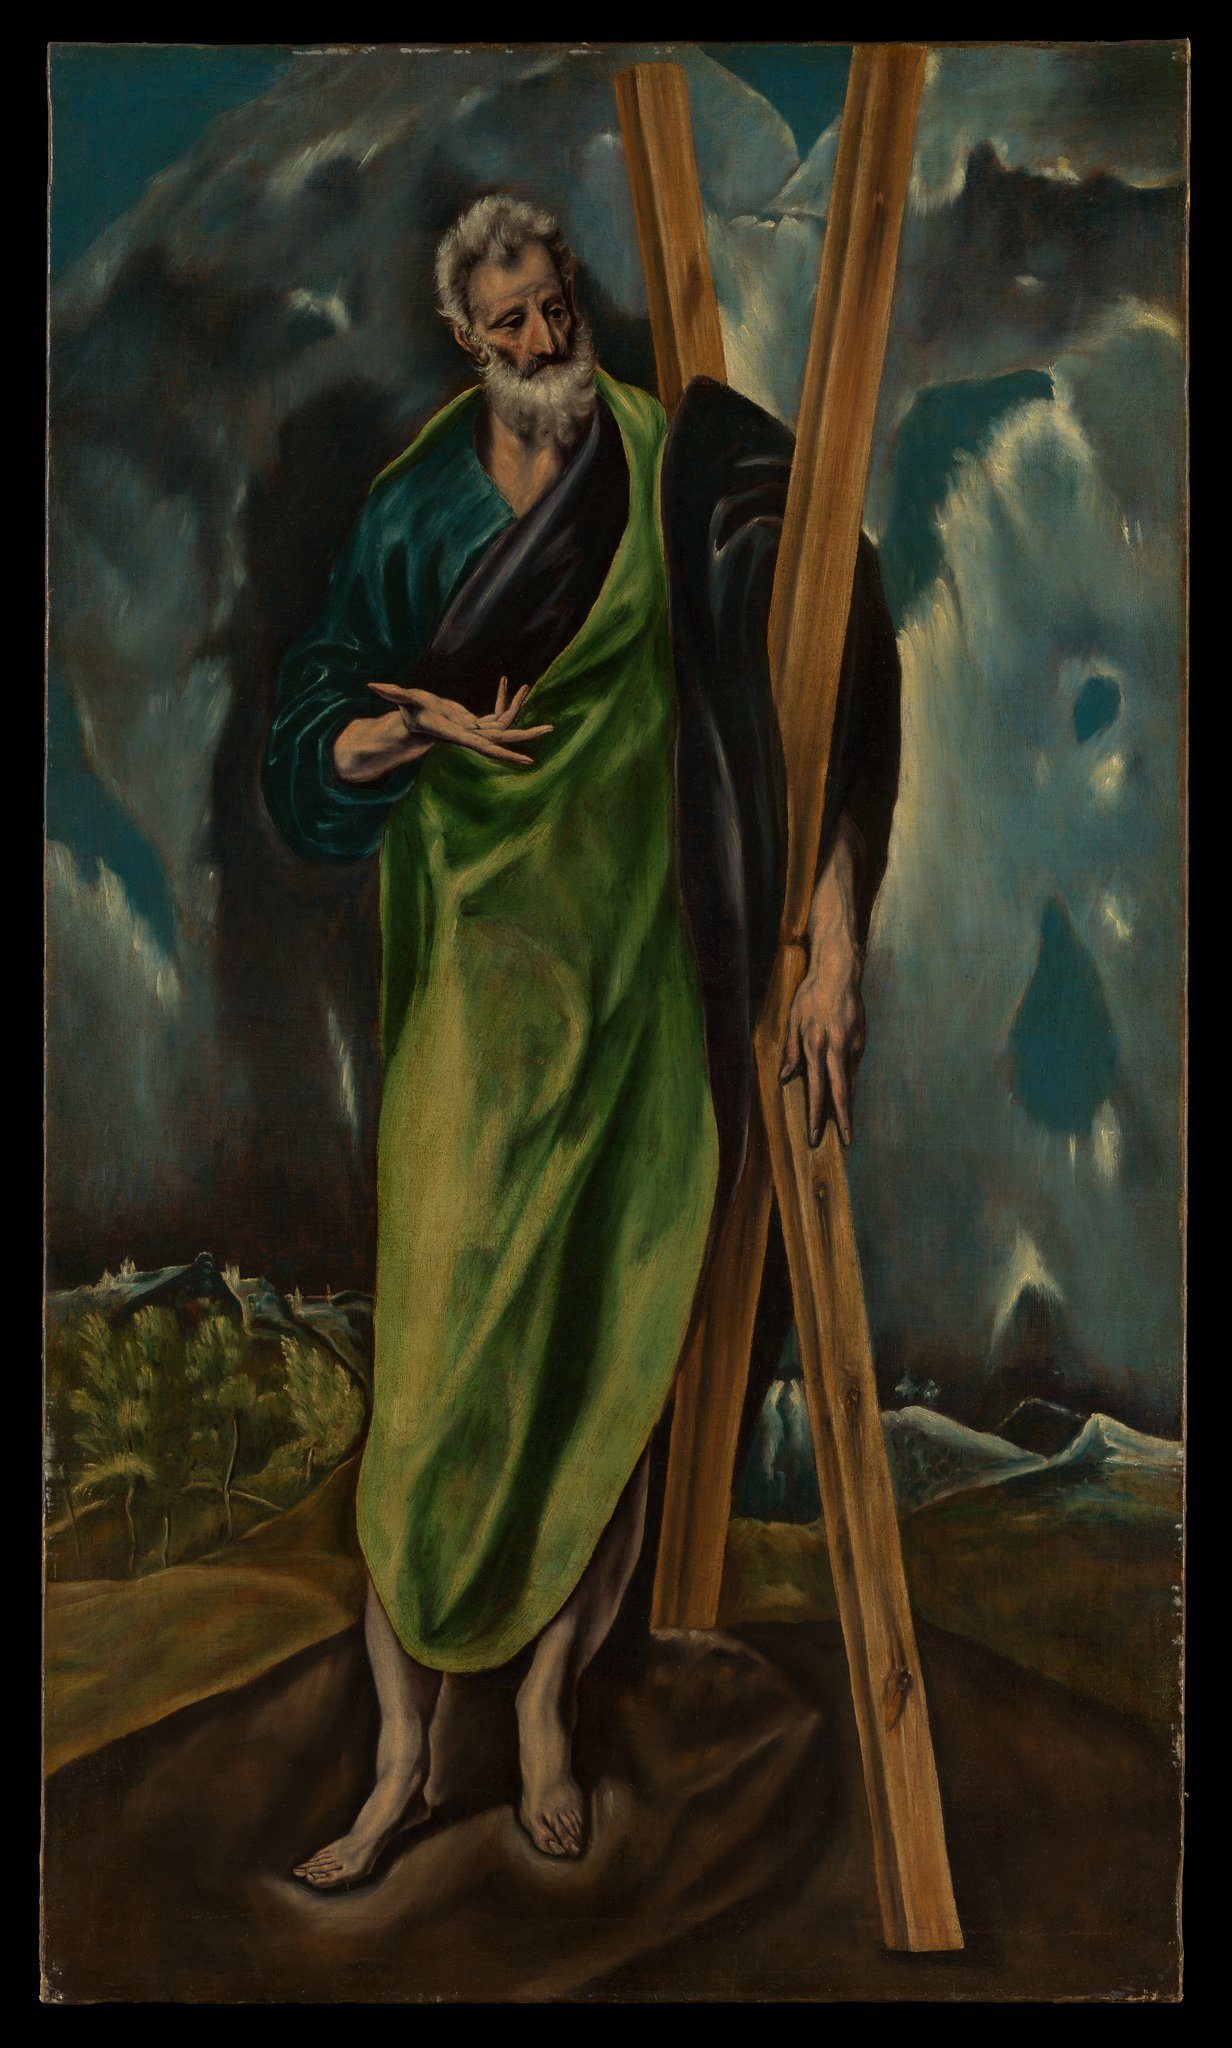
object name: painting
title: Saint Andrew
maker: el greco (domenikos theotokopoulos)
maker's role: artist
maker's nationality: greek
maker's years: 1540-1614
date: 1610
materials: canvas, oil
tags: men,saints